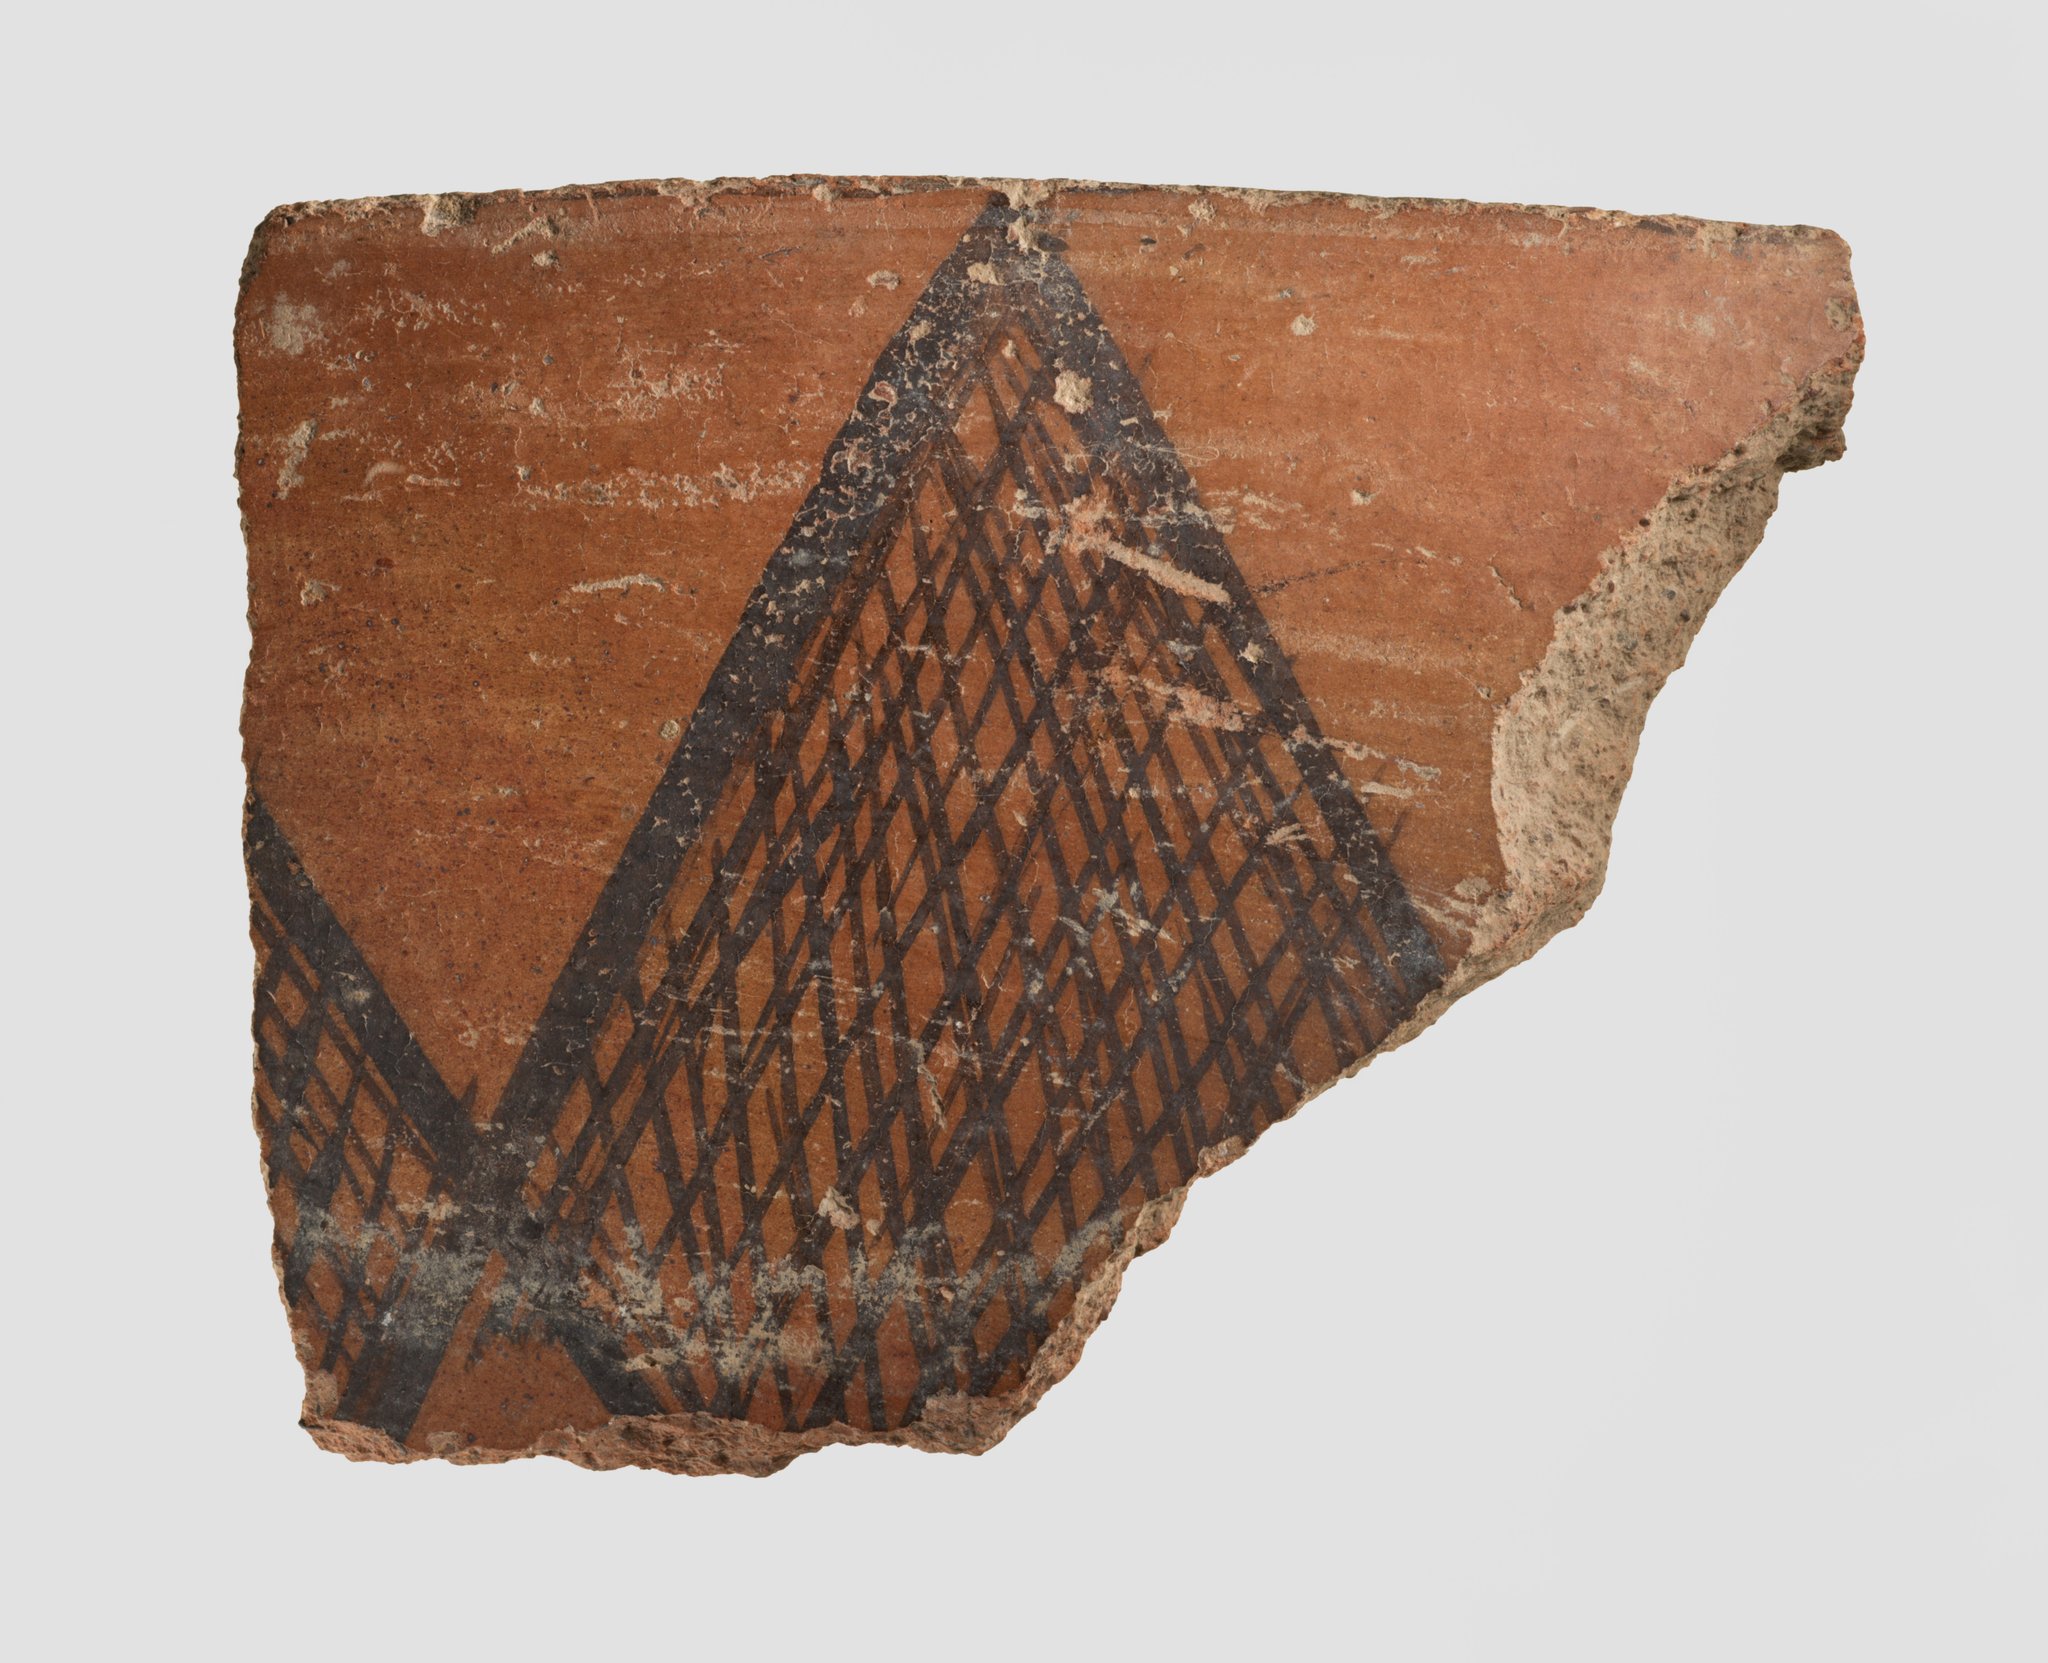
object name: sherd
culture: iranian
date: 1500-1000 BCE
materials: ceramic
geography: iran